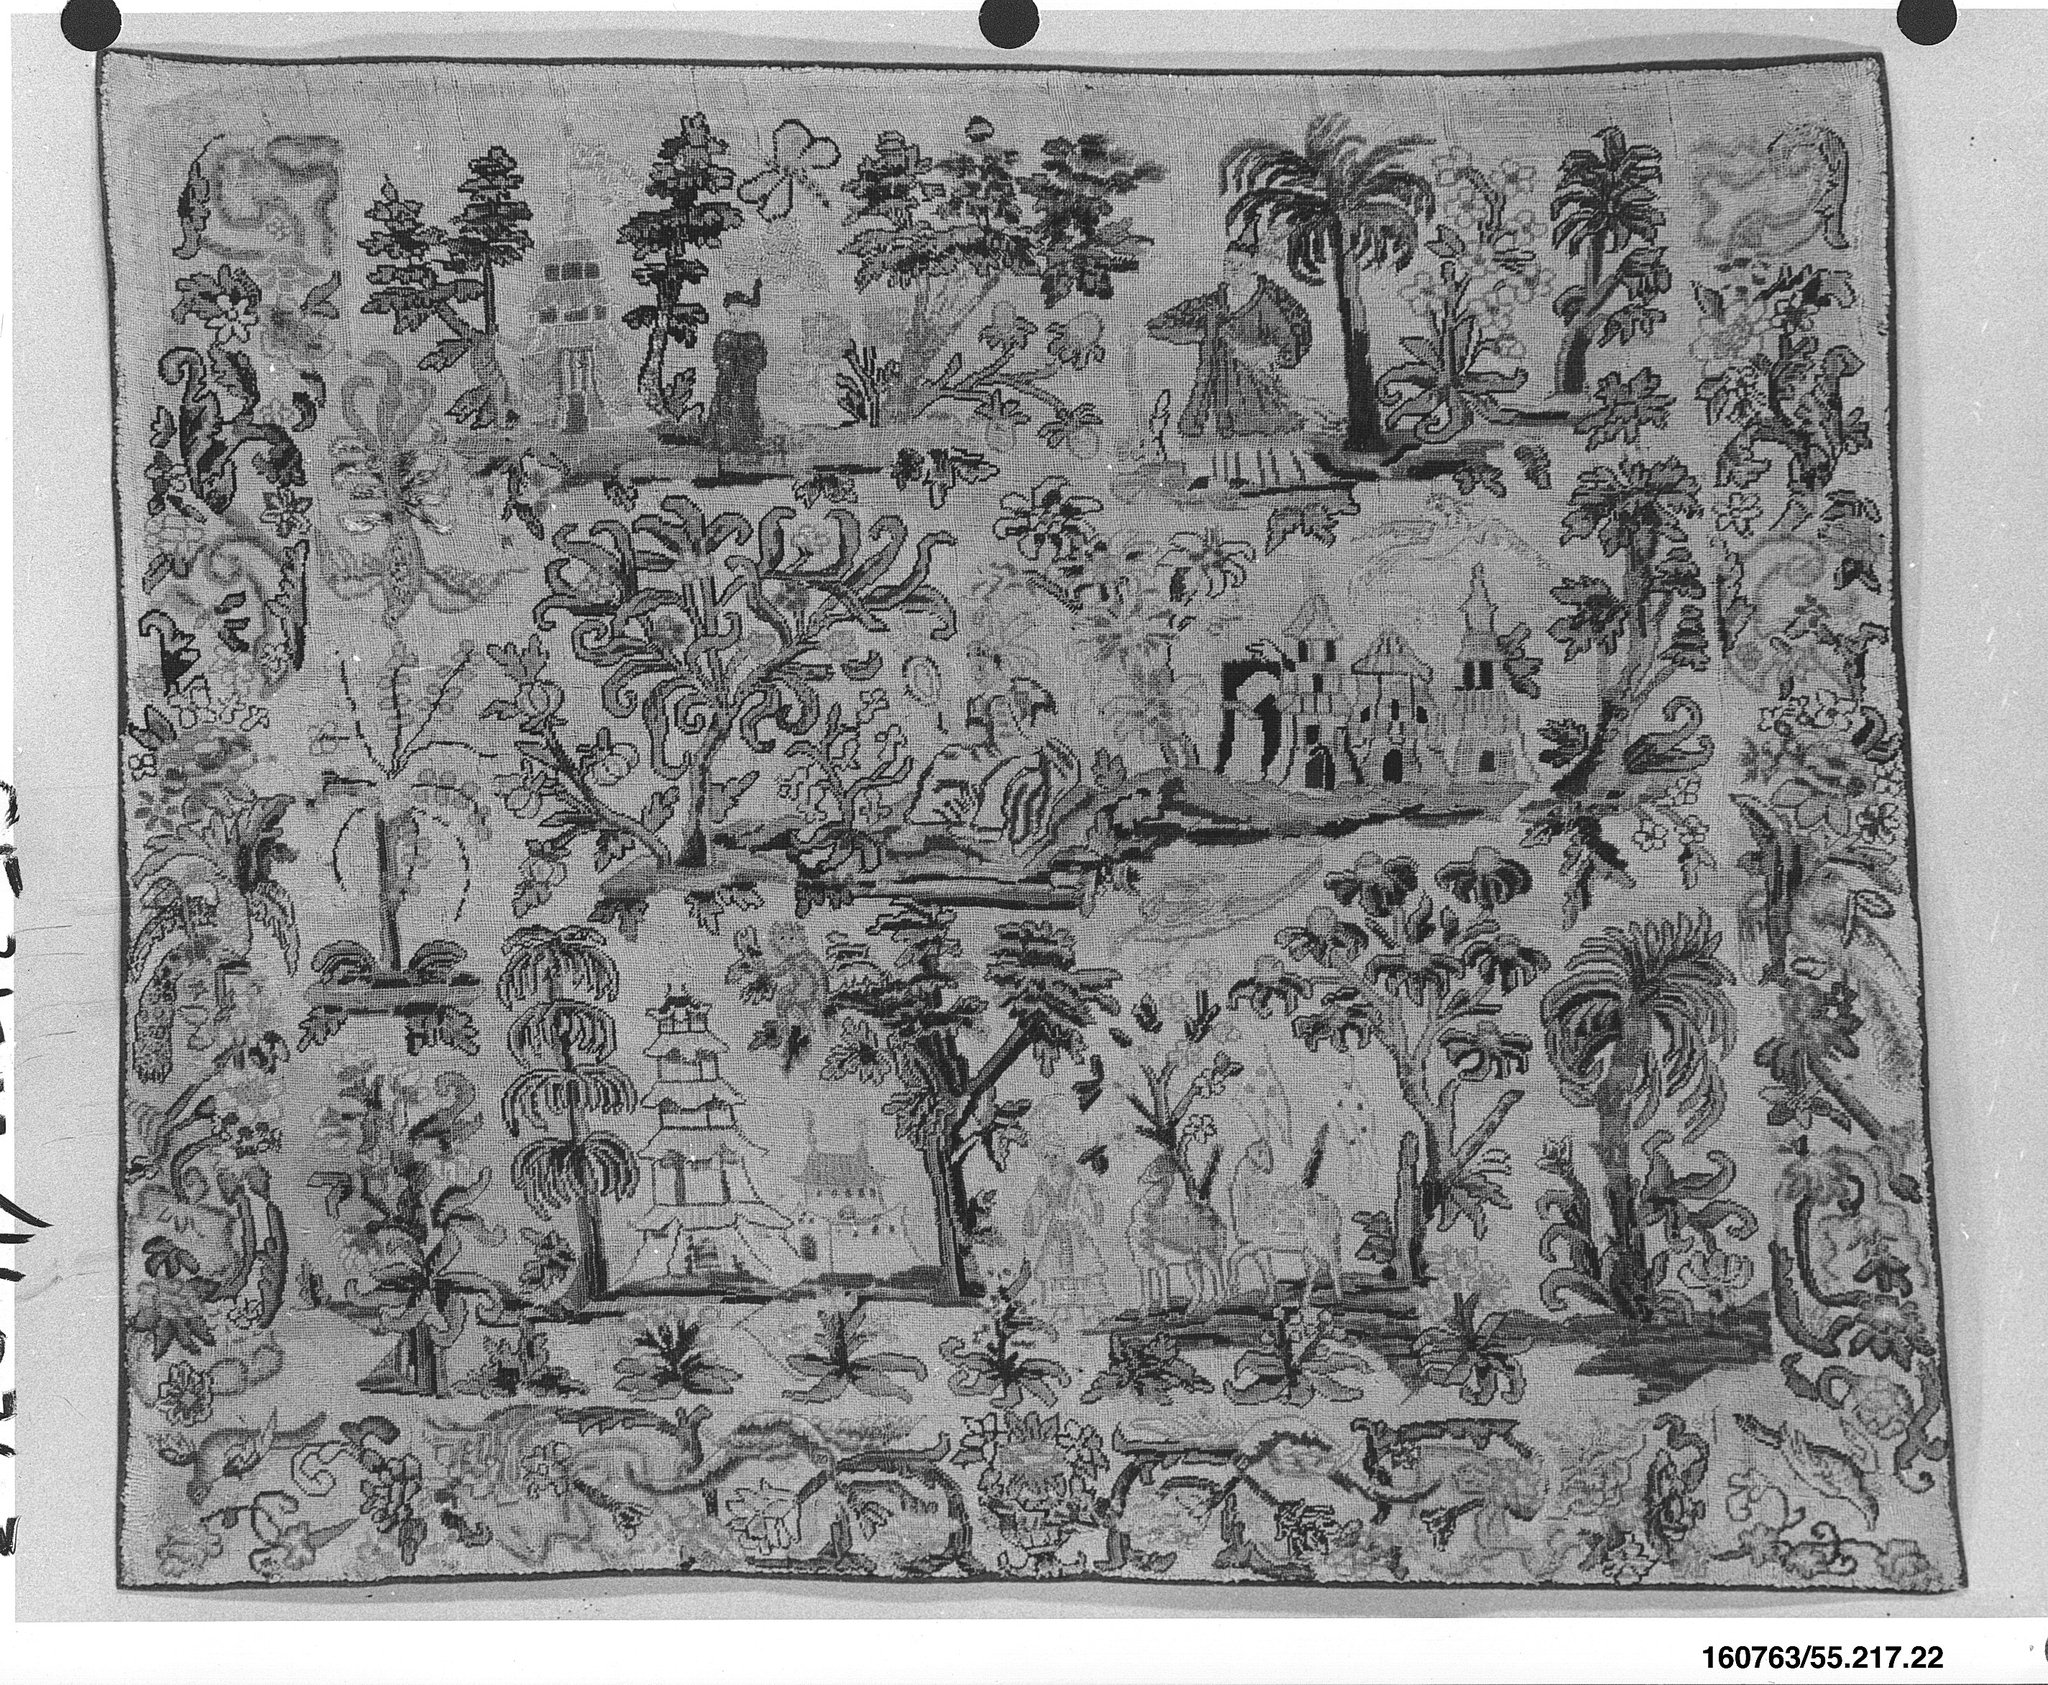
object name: panel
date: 1701-1750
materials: canvas, silk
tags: human figures,birds,chinoiserie,deer